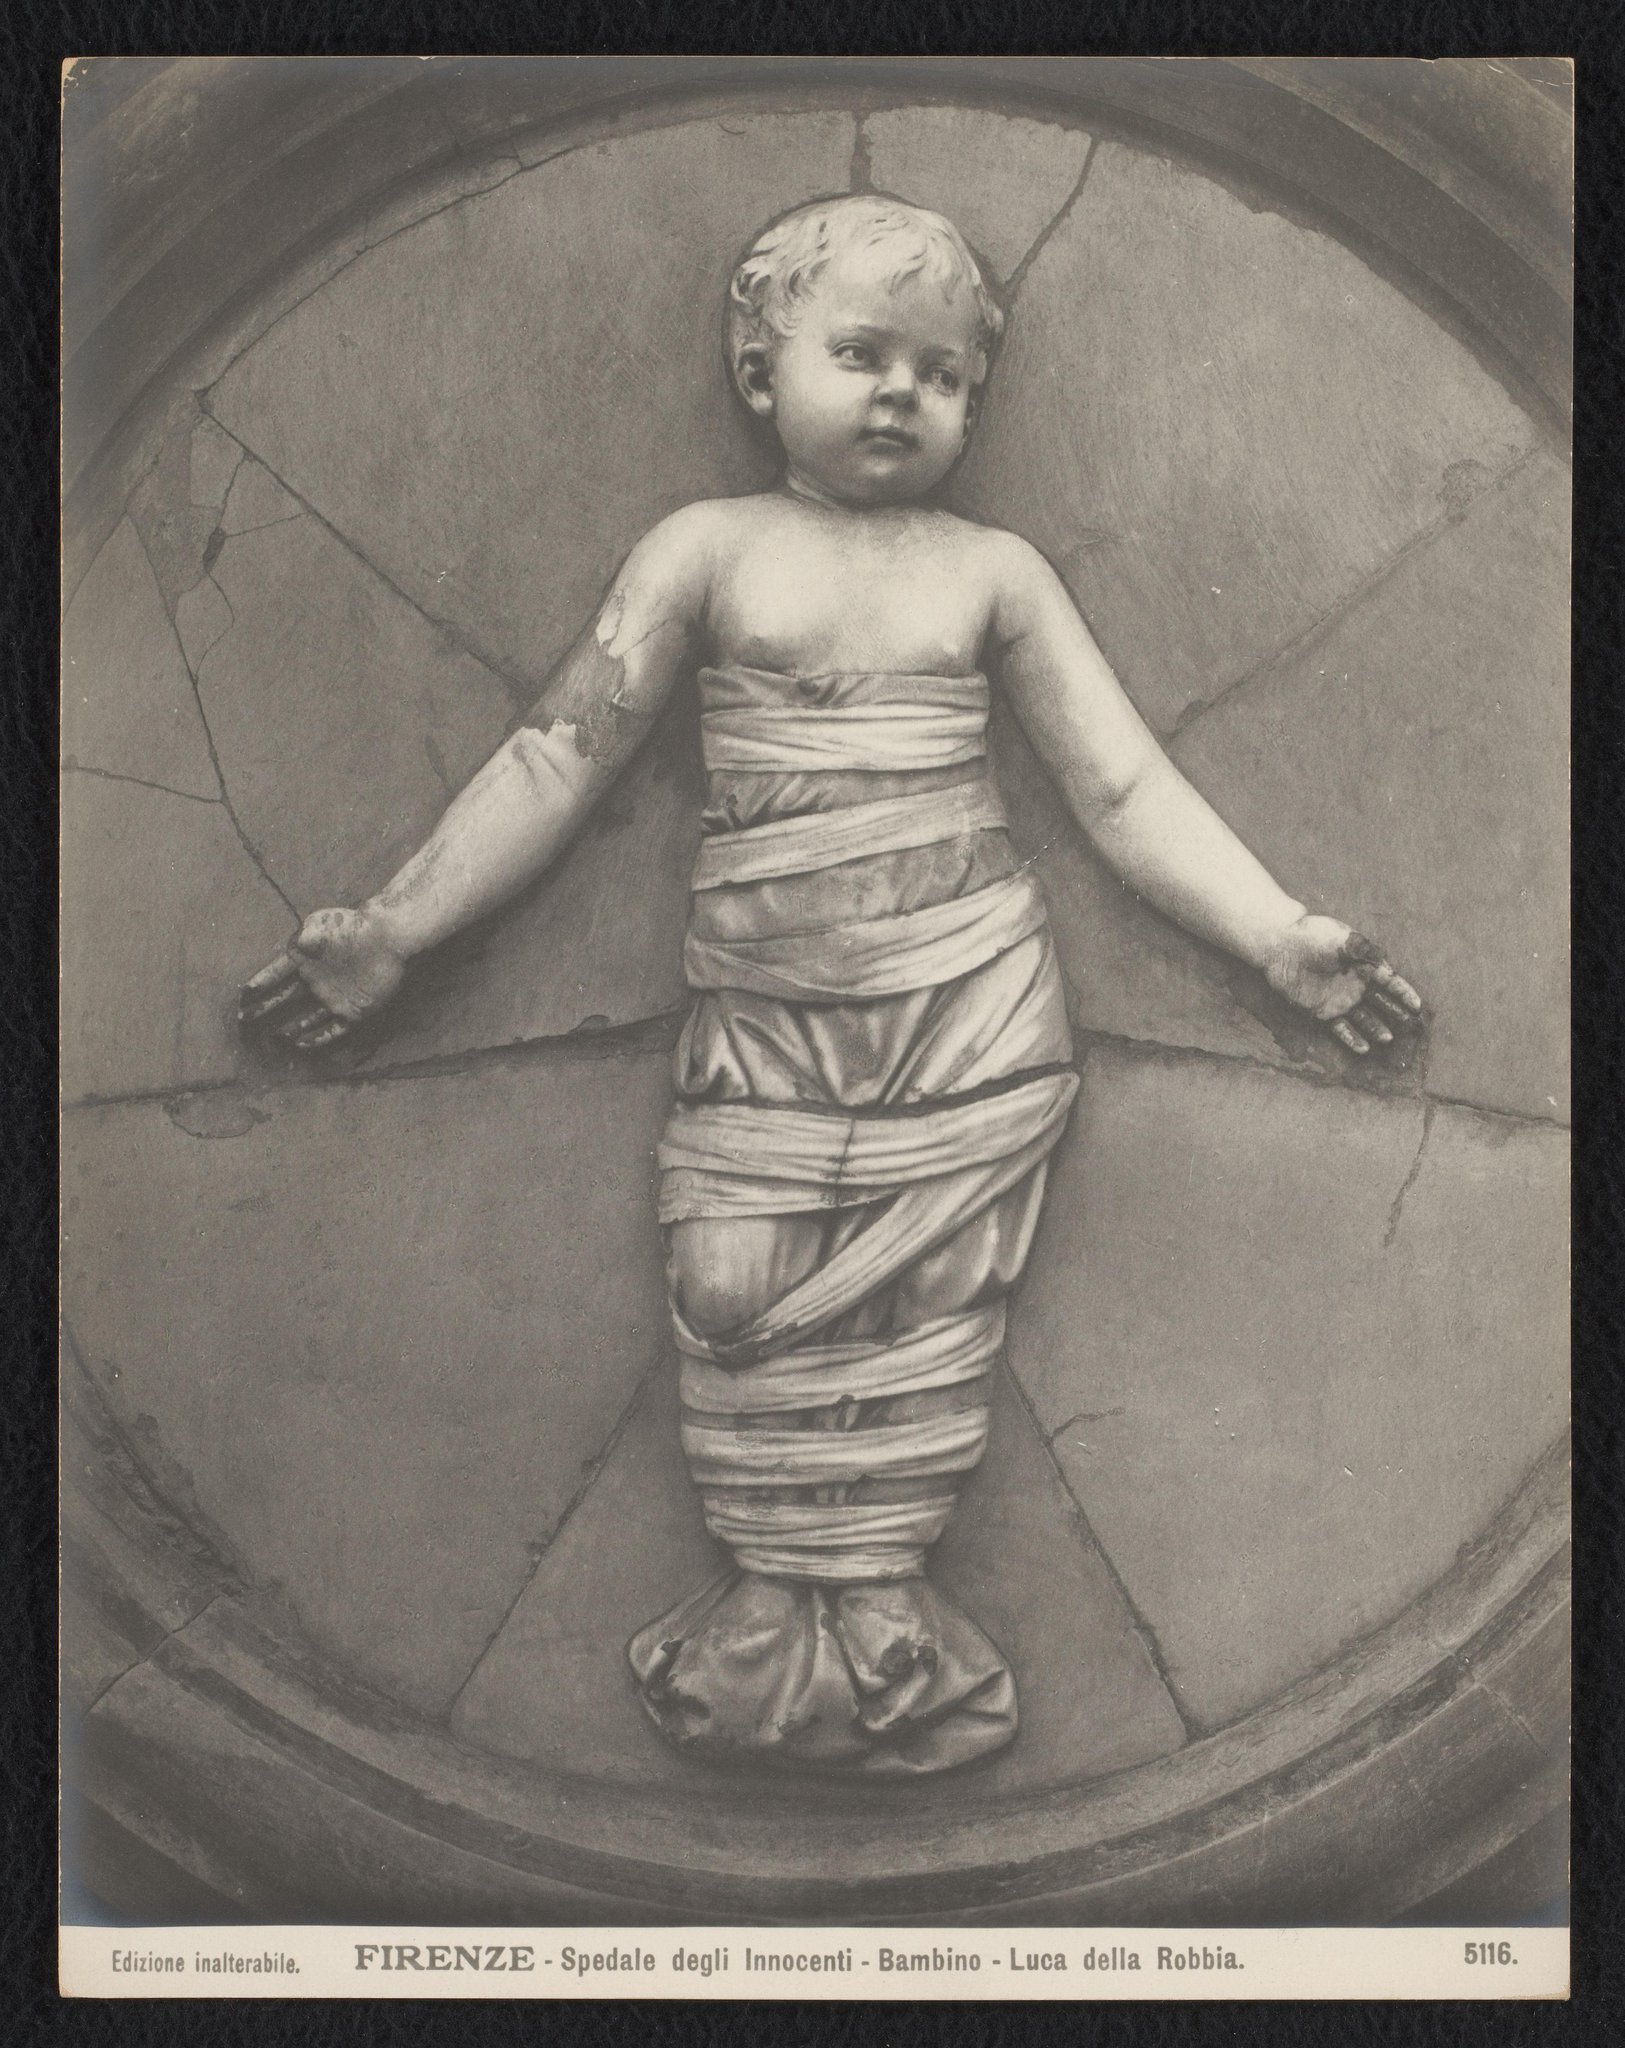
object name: photograph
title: Tondo met baby door Andrea della Robbia aan het Ospedale degli Innocenti te Florence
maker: Anonymous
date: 1900-1920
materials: paper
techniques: gelatin silver print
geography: florence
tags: art (+ relief ~ sculpture)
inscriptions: collector's mark: ‘RIJKS SCHOOL VOOR KUNSTNIJVERHEID/ GROEP’, number: ‘5116.’, inscription: ‘Edizione inalterabile.’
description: Deze foto maakt deel uit van een omslag.